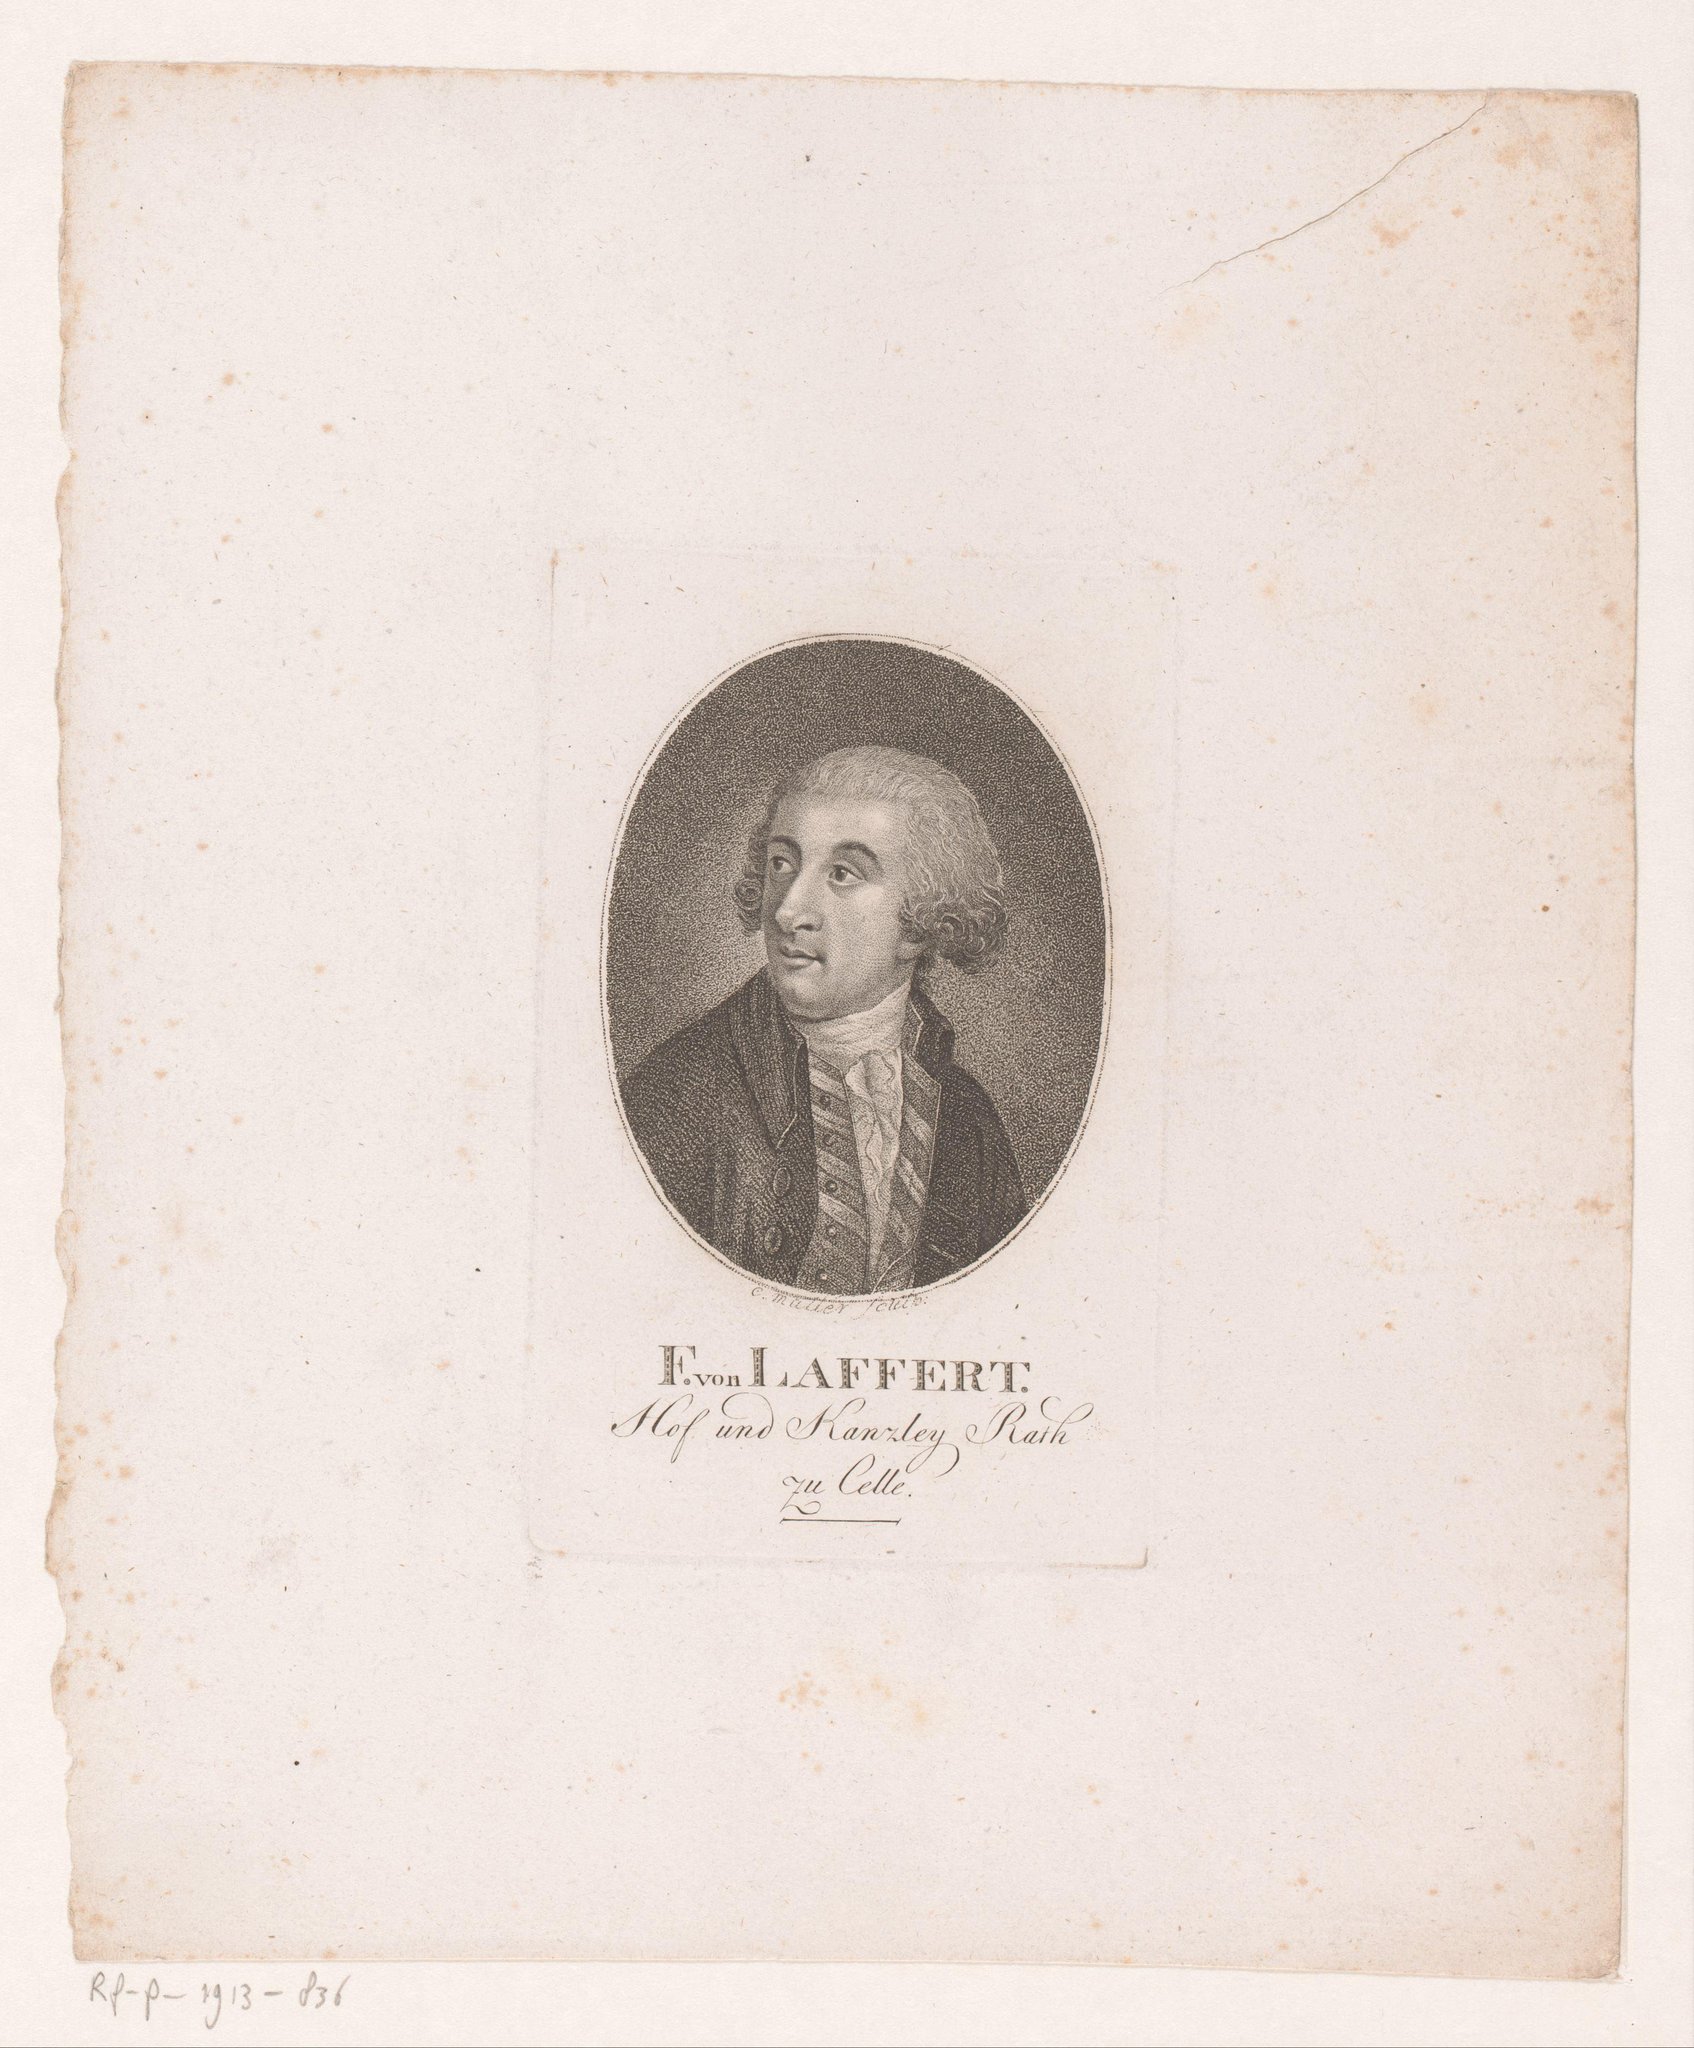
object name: print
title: Portret van Ludolph Friedrich von Laffert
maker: johann christian ernst müller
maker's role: draughtsman, print maker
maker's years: 1766-1824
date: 1801-1824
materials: paper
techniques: engraving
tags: painter, historical persons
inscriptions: collector's mark: Lugt 2228